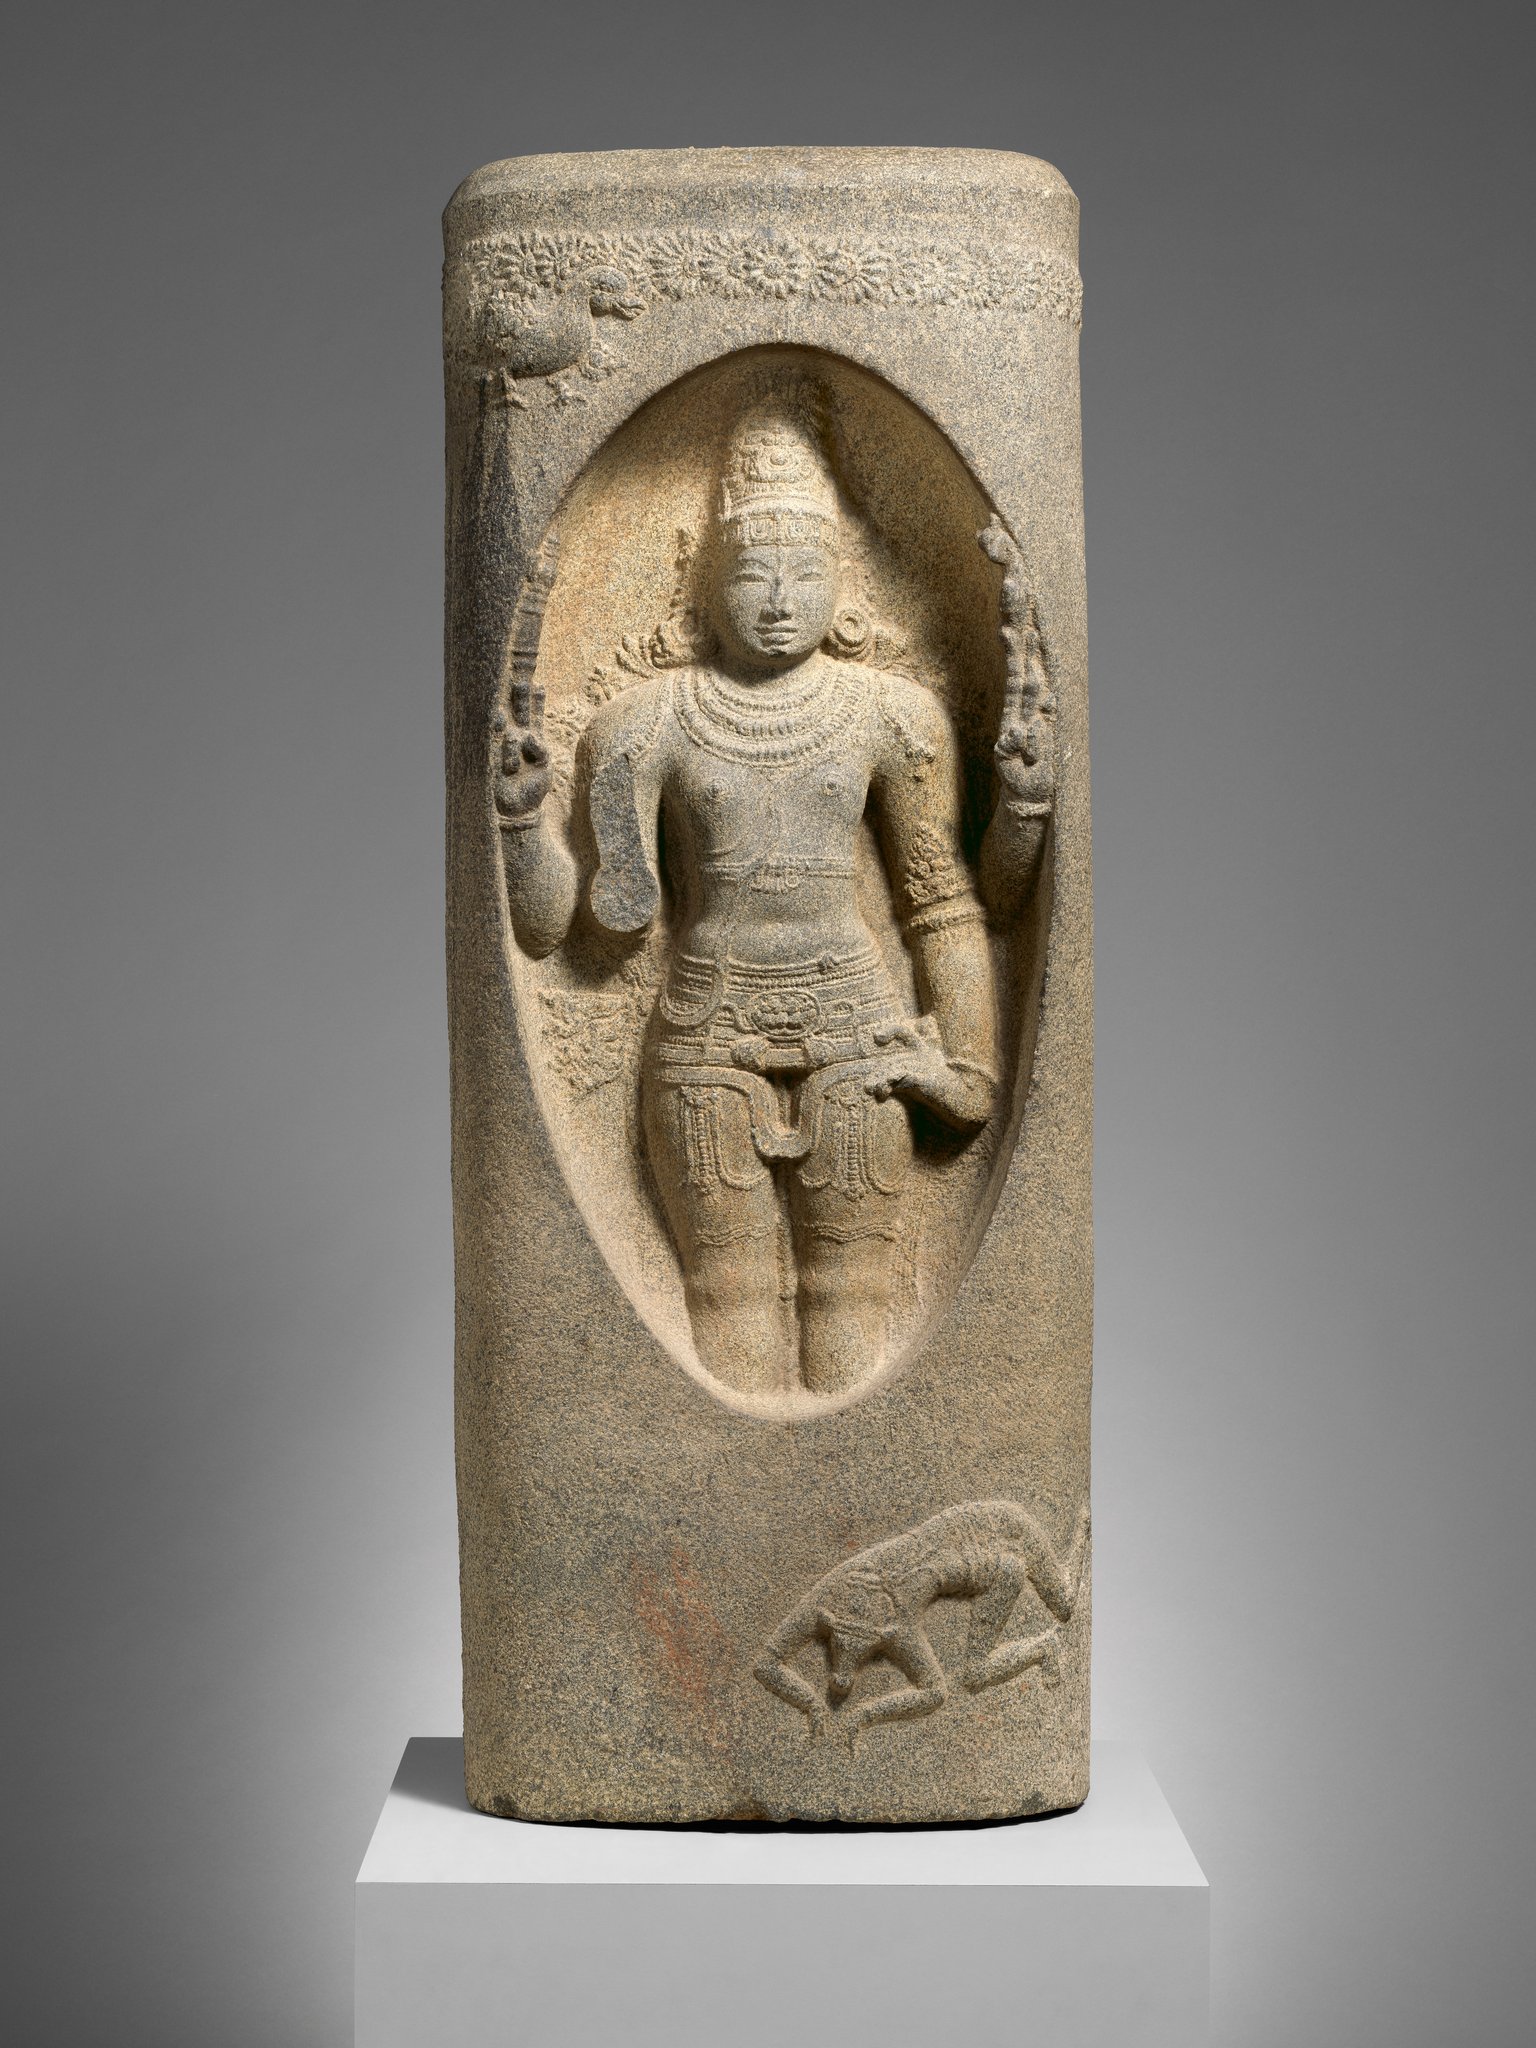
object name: carved pillar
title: Shiva Emerging from the Linga (Lingodbhavamurti)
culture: indian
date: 1101-1200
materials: stone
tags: shiva,hinduism